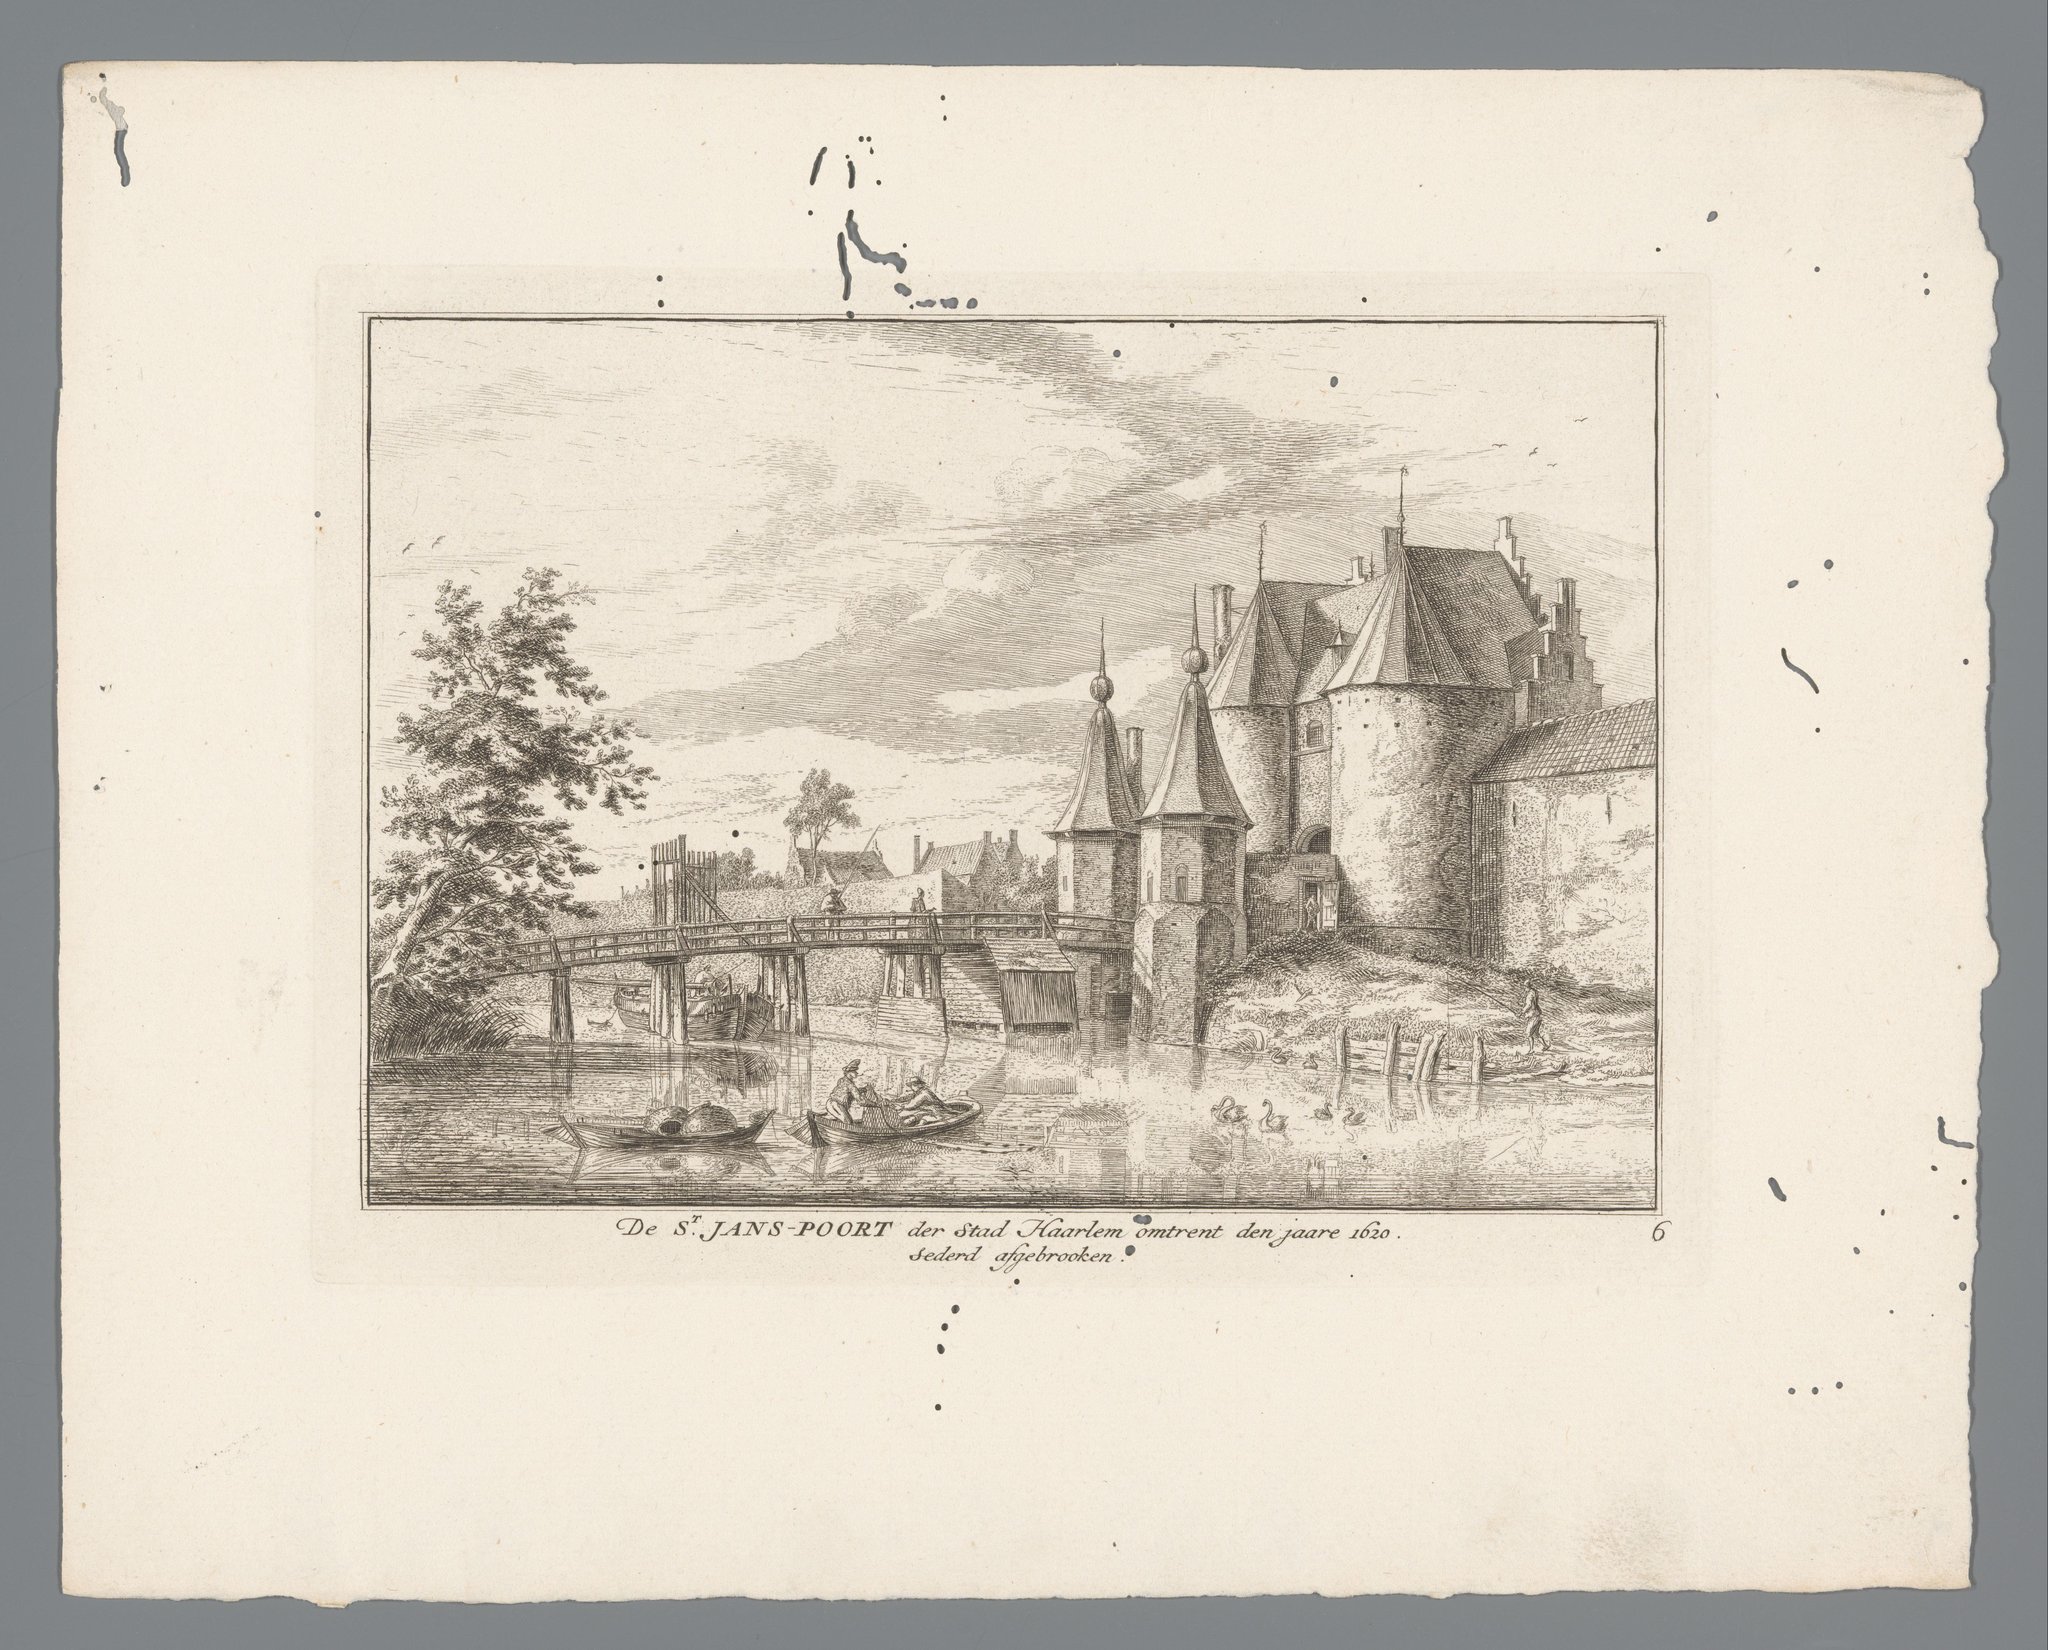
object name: print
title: De St. Jans-poort der stad Haarlem omtrent den jaare 1620. Sederd afgebrooken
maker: hendrik spilman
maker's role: draughtsman, painter, print maker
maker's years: 1721-1784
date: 1739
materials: paper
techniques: engraving, etching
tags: rowing-boat, canoe, etc., bridge in city across river, canal, etc., city-gate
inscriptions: collector's mark: Lugt 2228